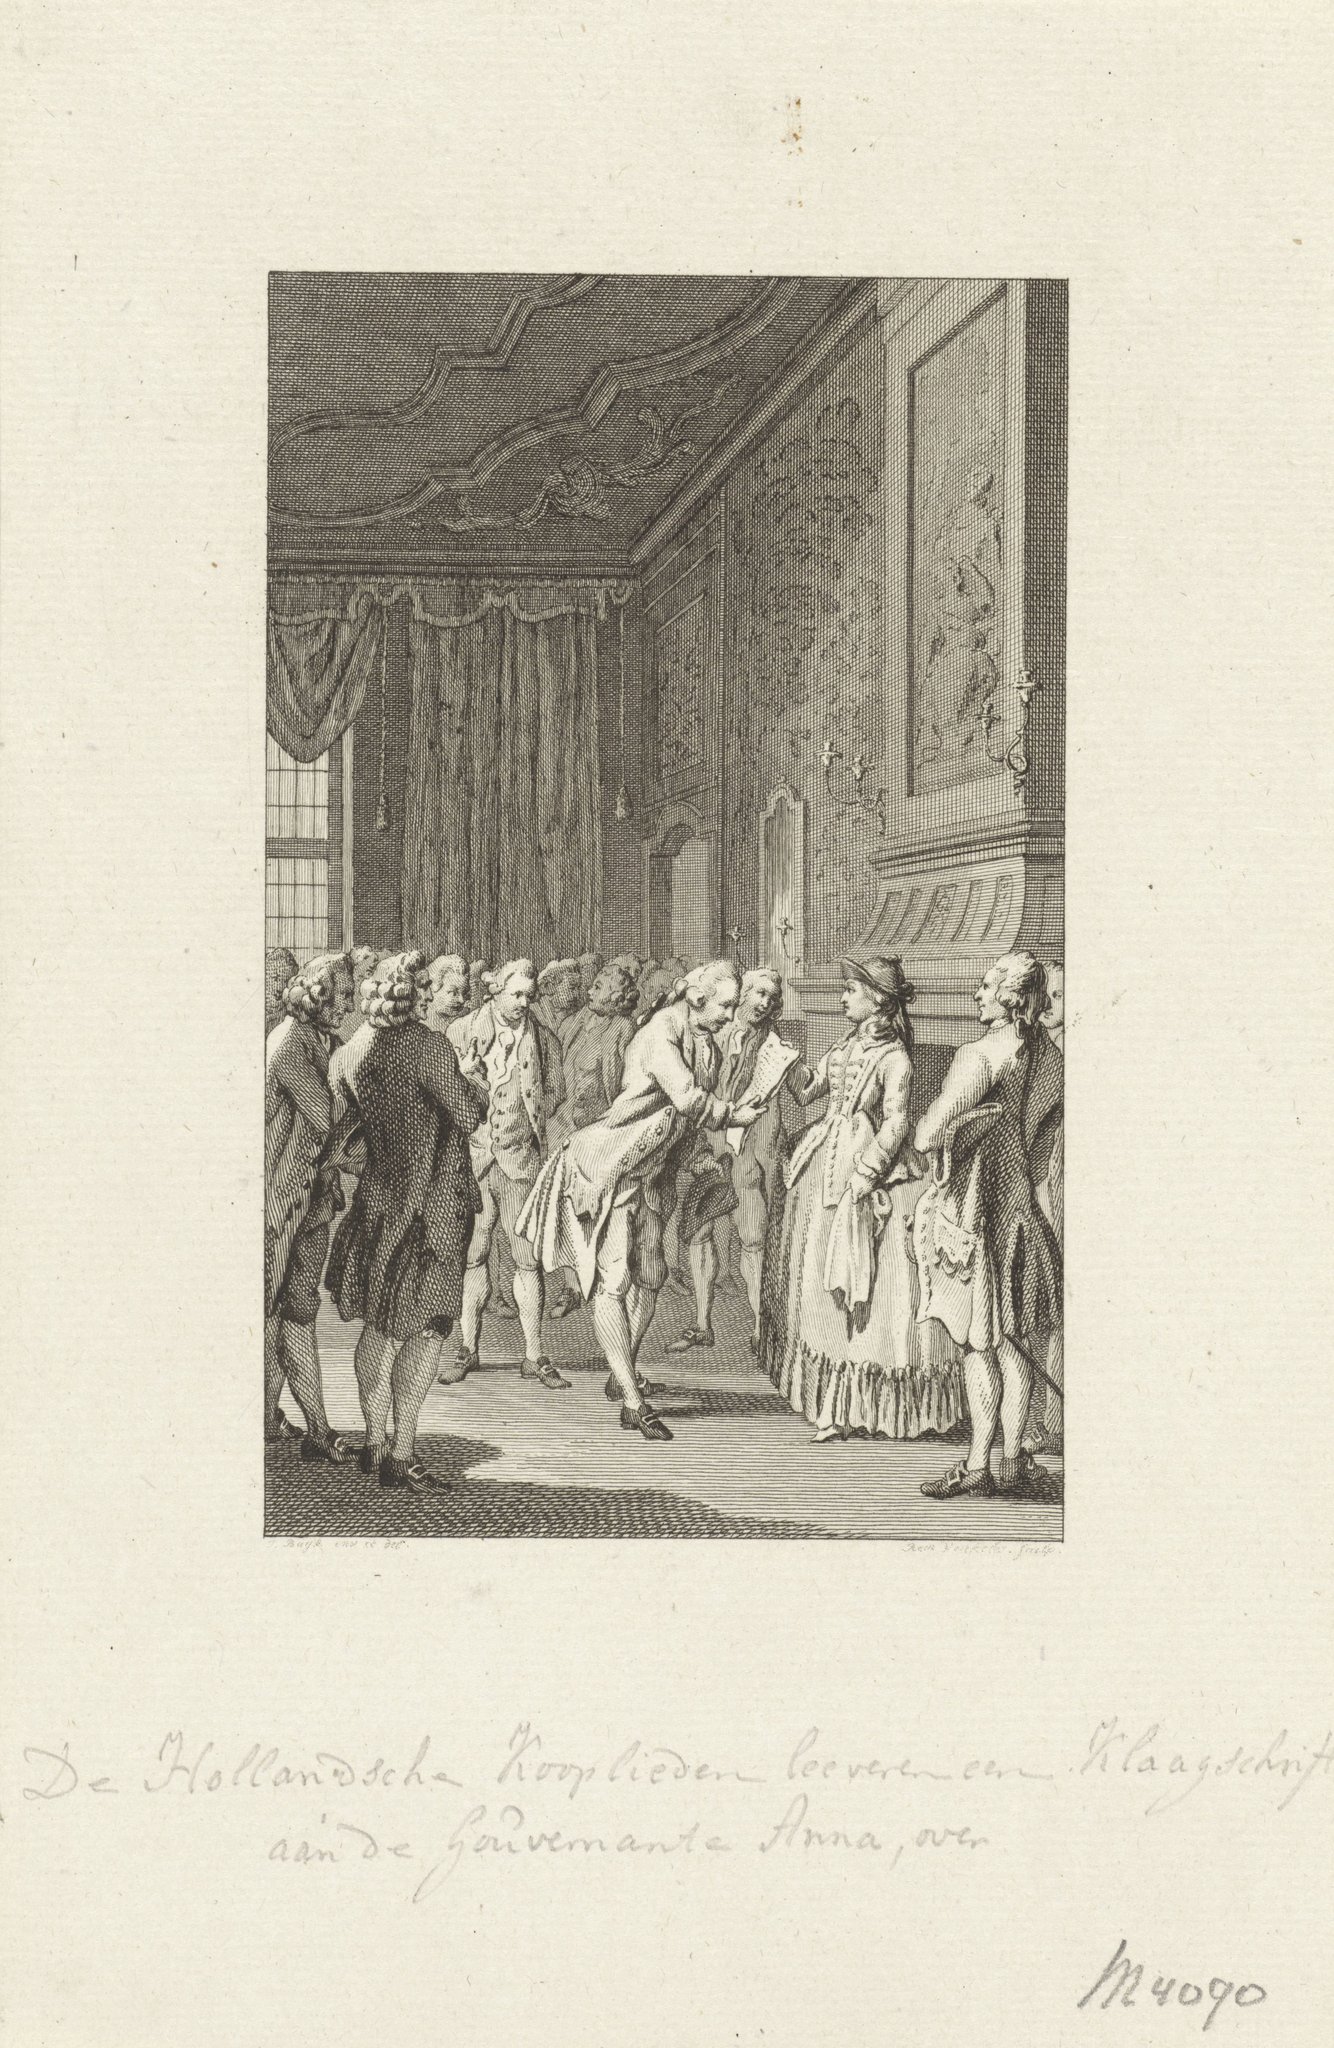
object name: history print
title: Hollandse kooplieden overhandigen prinses Anna een klaagschrift over de Engelse aanvallen, 1758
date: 1788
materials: paper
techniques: engraving, etching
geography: amsterdam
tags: anna van hannover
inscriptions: collector's mark: Lugt 240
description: Een delegatie van Hollandse kooplieden overhandigt aan de gouvernante (prinses Anna van Hannover) een klaagschrift over de Engelse aanvallen, 7 december 1758. Waarschijnlijk naar aanleiding van overvallen door de Engelsen op Nederlandse schepen in de Antillen.